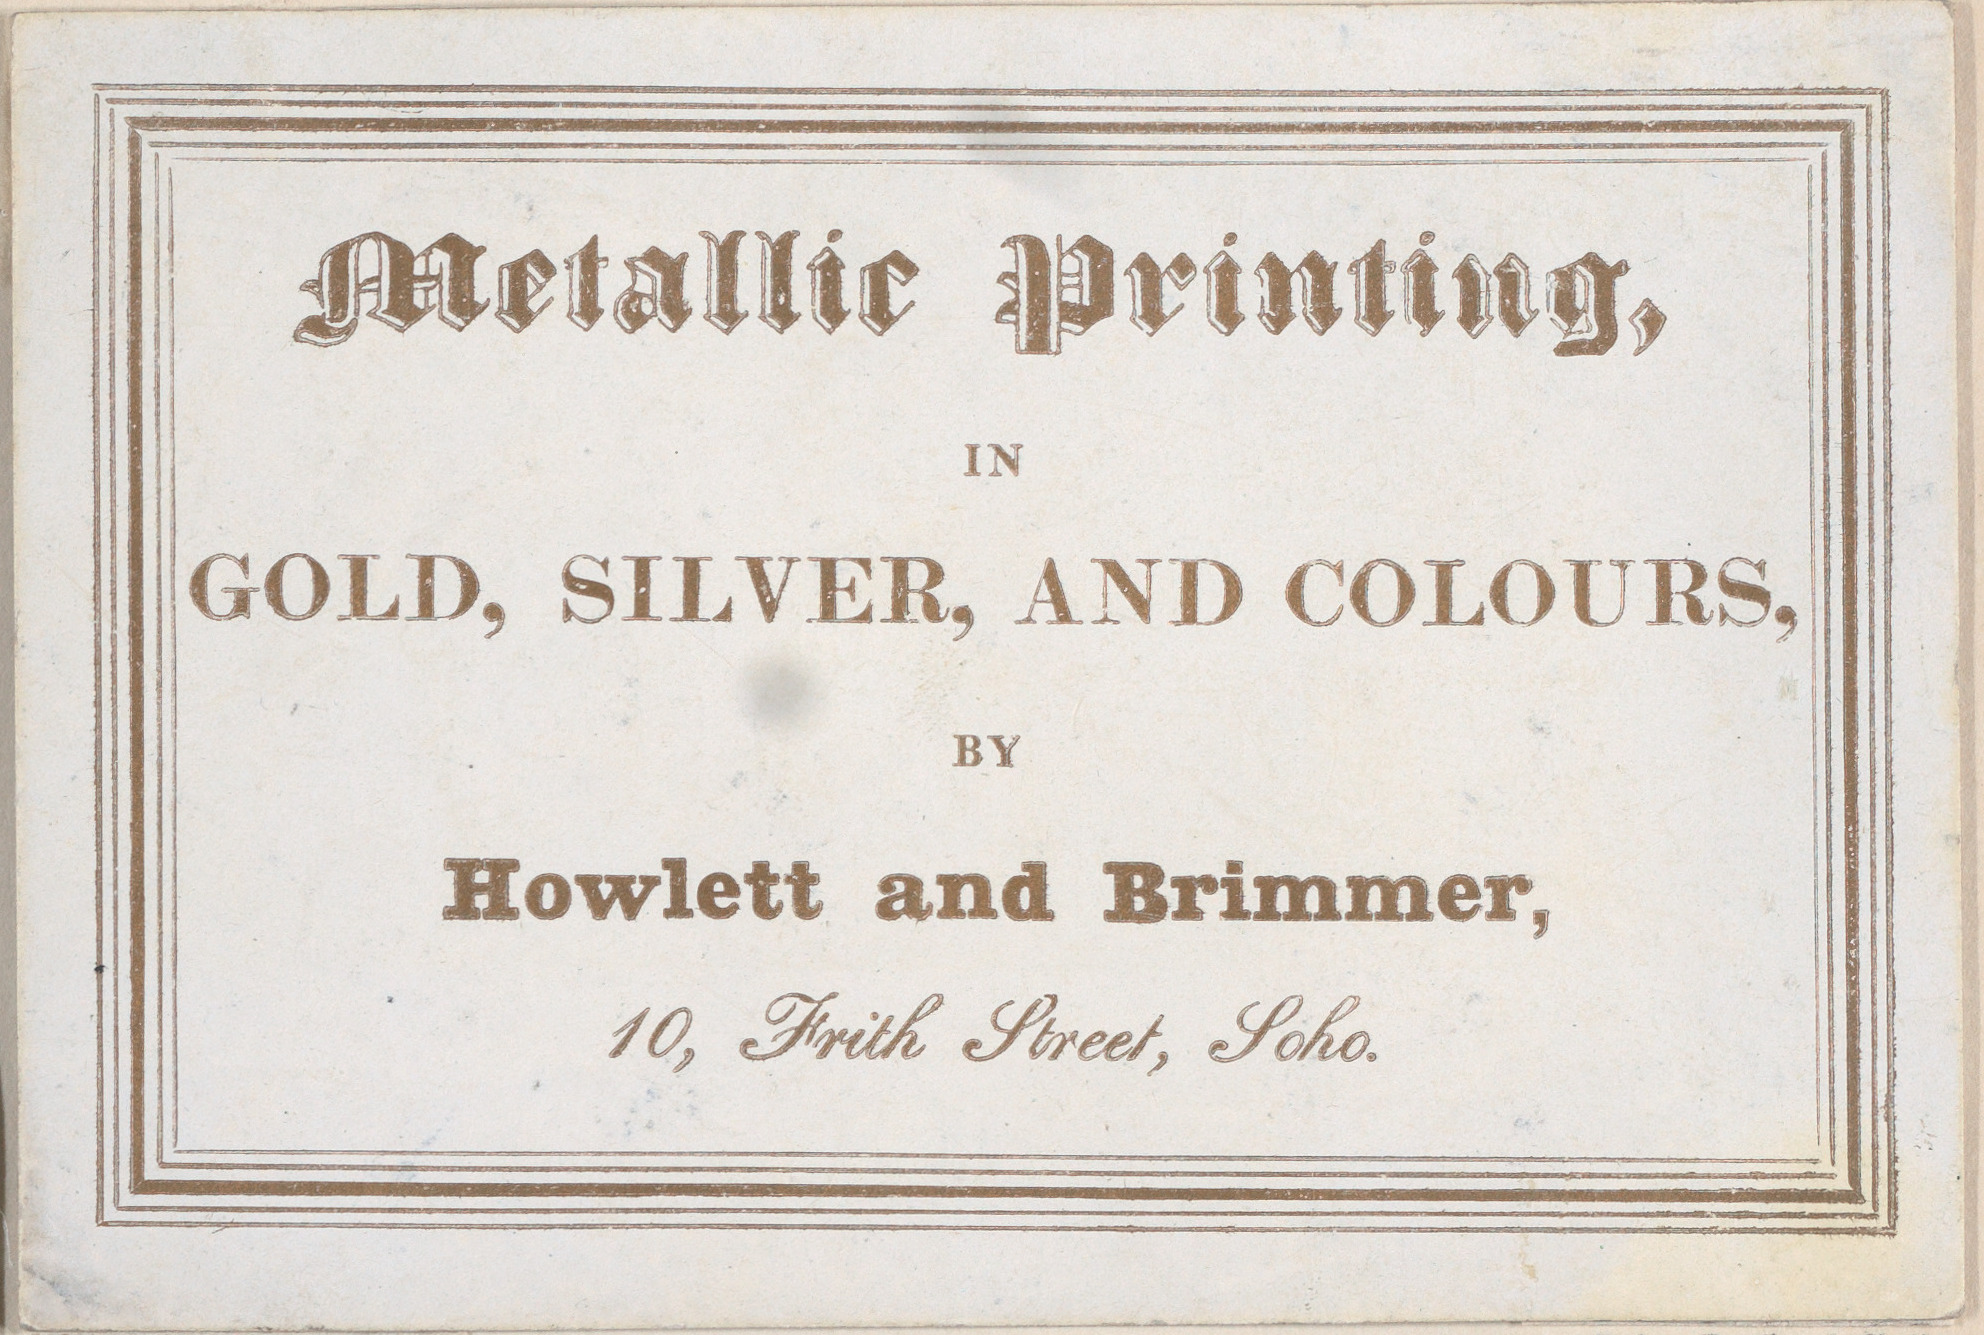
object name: print, trade card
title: Trade card for Howlett and Brimmer, Metallic Printer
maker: anonymous, british, 18th century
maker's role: artist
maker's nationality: british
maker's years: 1700-1800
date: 1801-1900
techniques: engraving